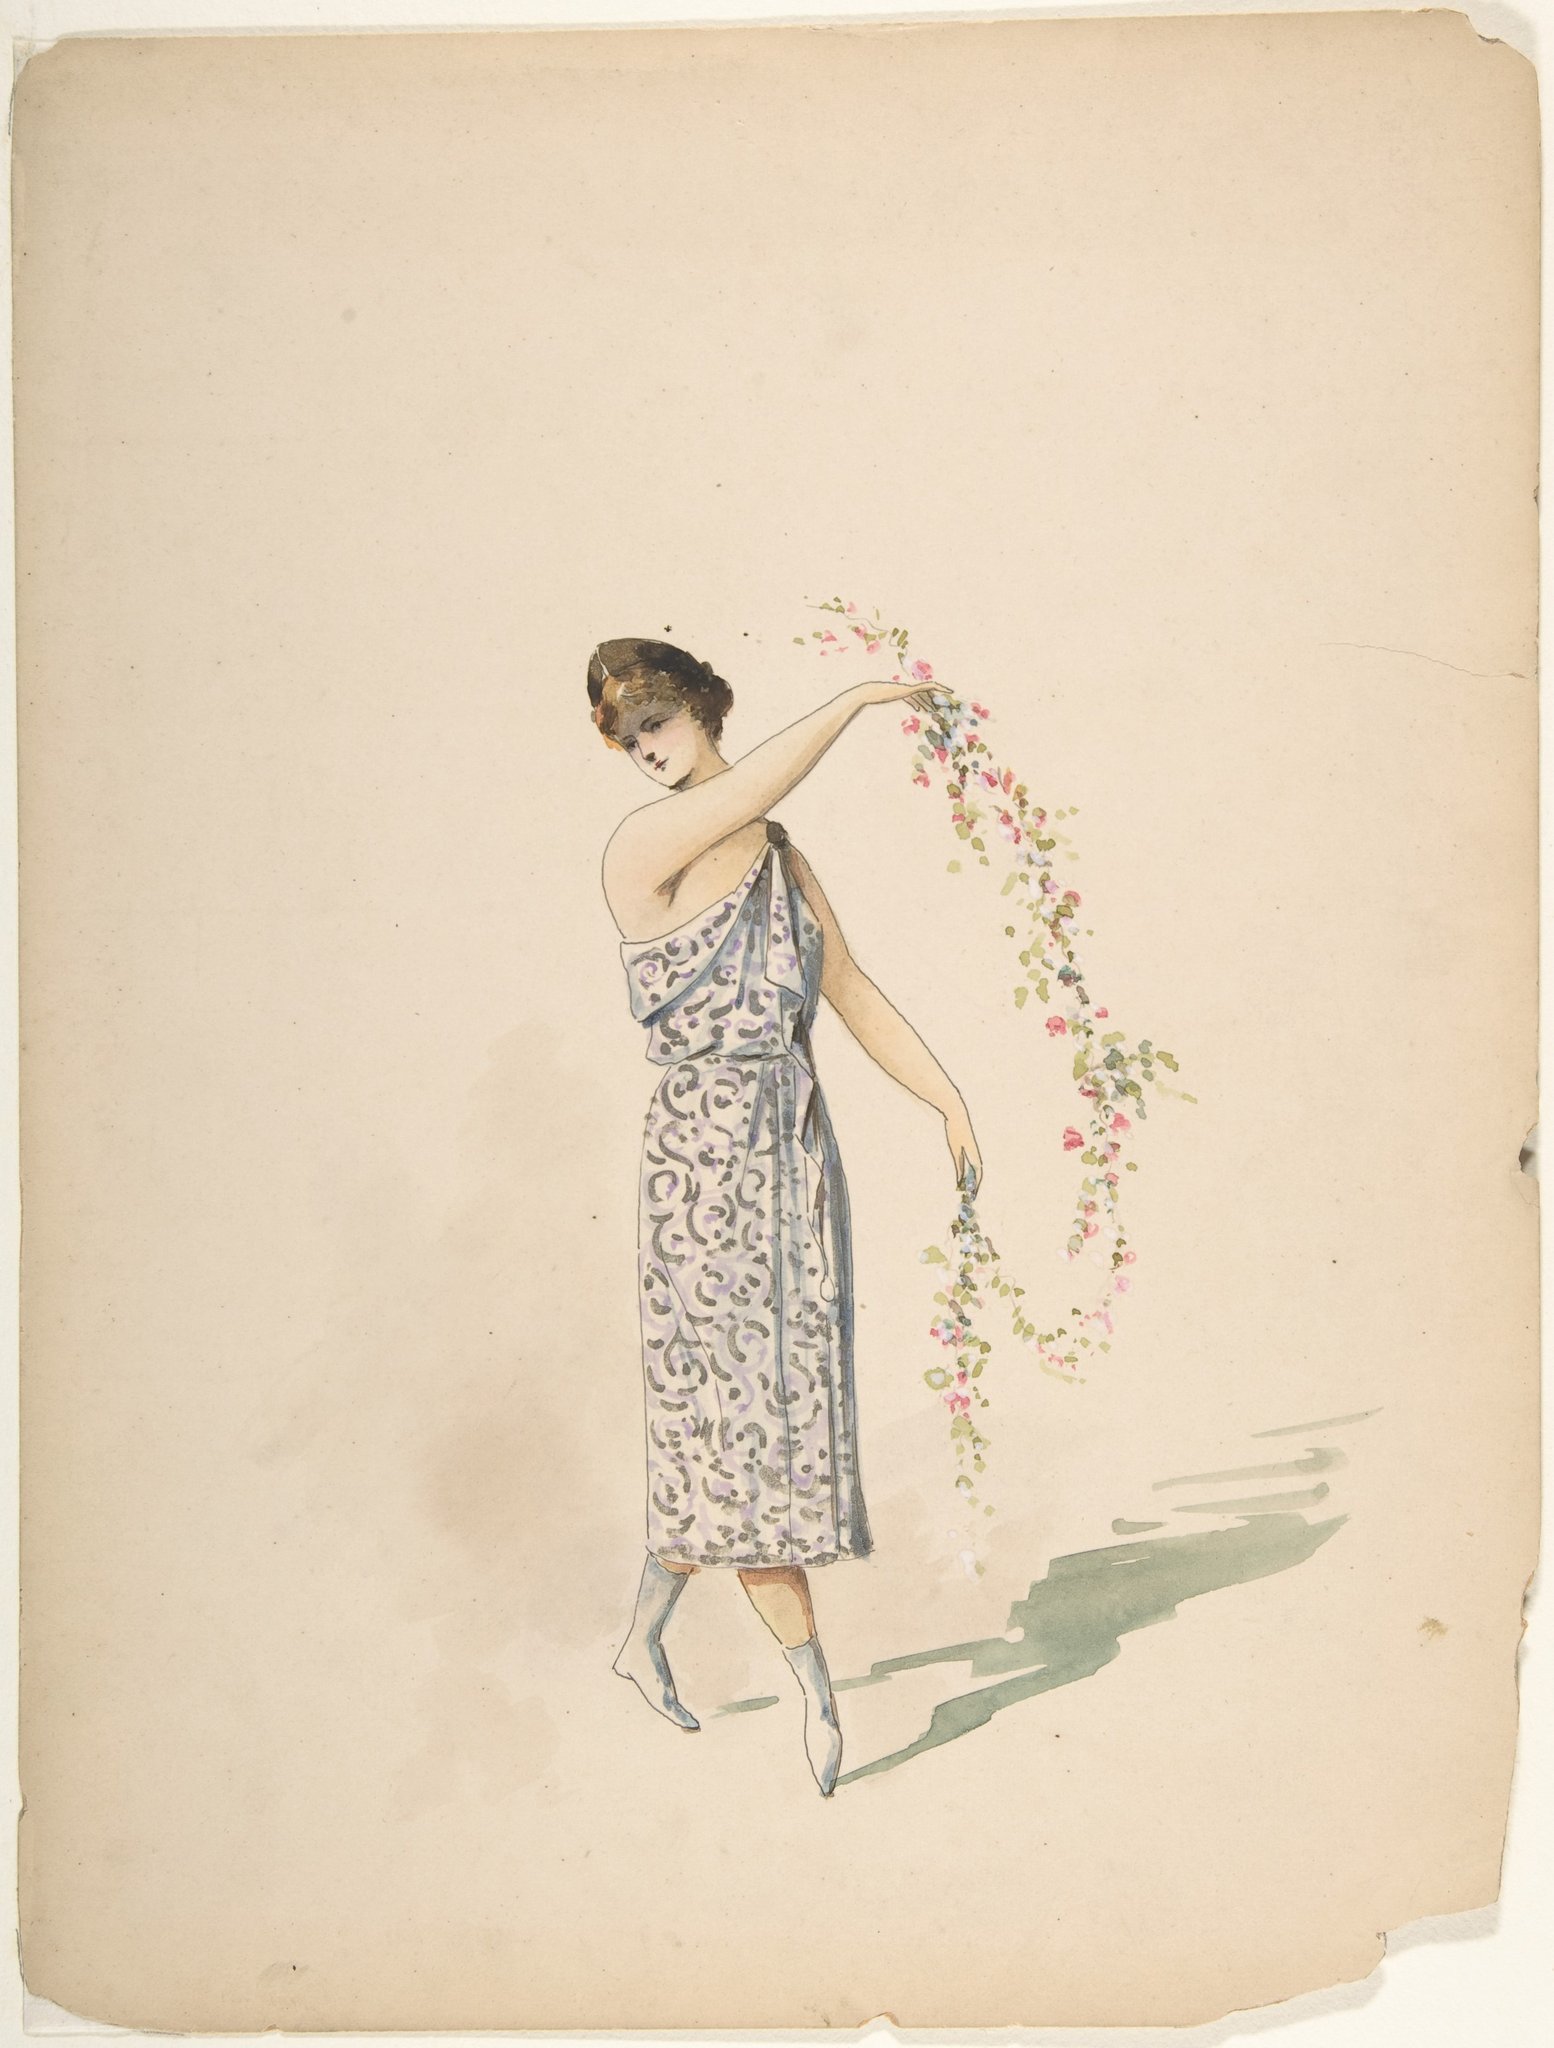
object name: drawing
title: Costume Design for a Maiden Draped in White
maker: charles bianchini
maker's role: artist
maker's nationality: french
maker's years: 1860-1905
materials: ink, watercolor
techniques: pen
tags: costumes,women